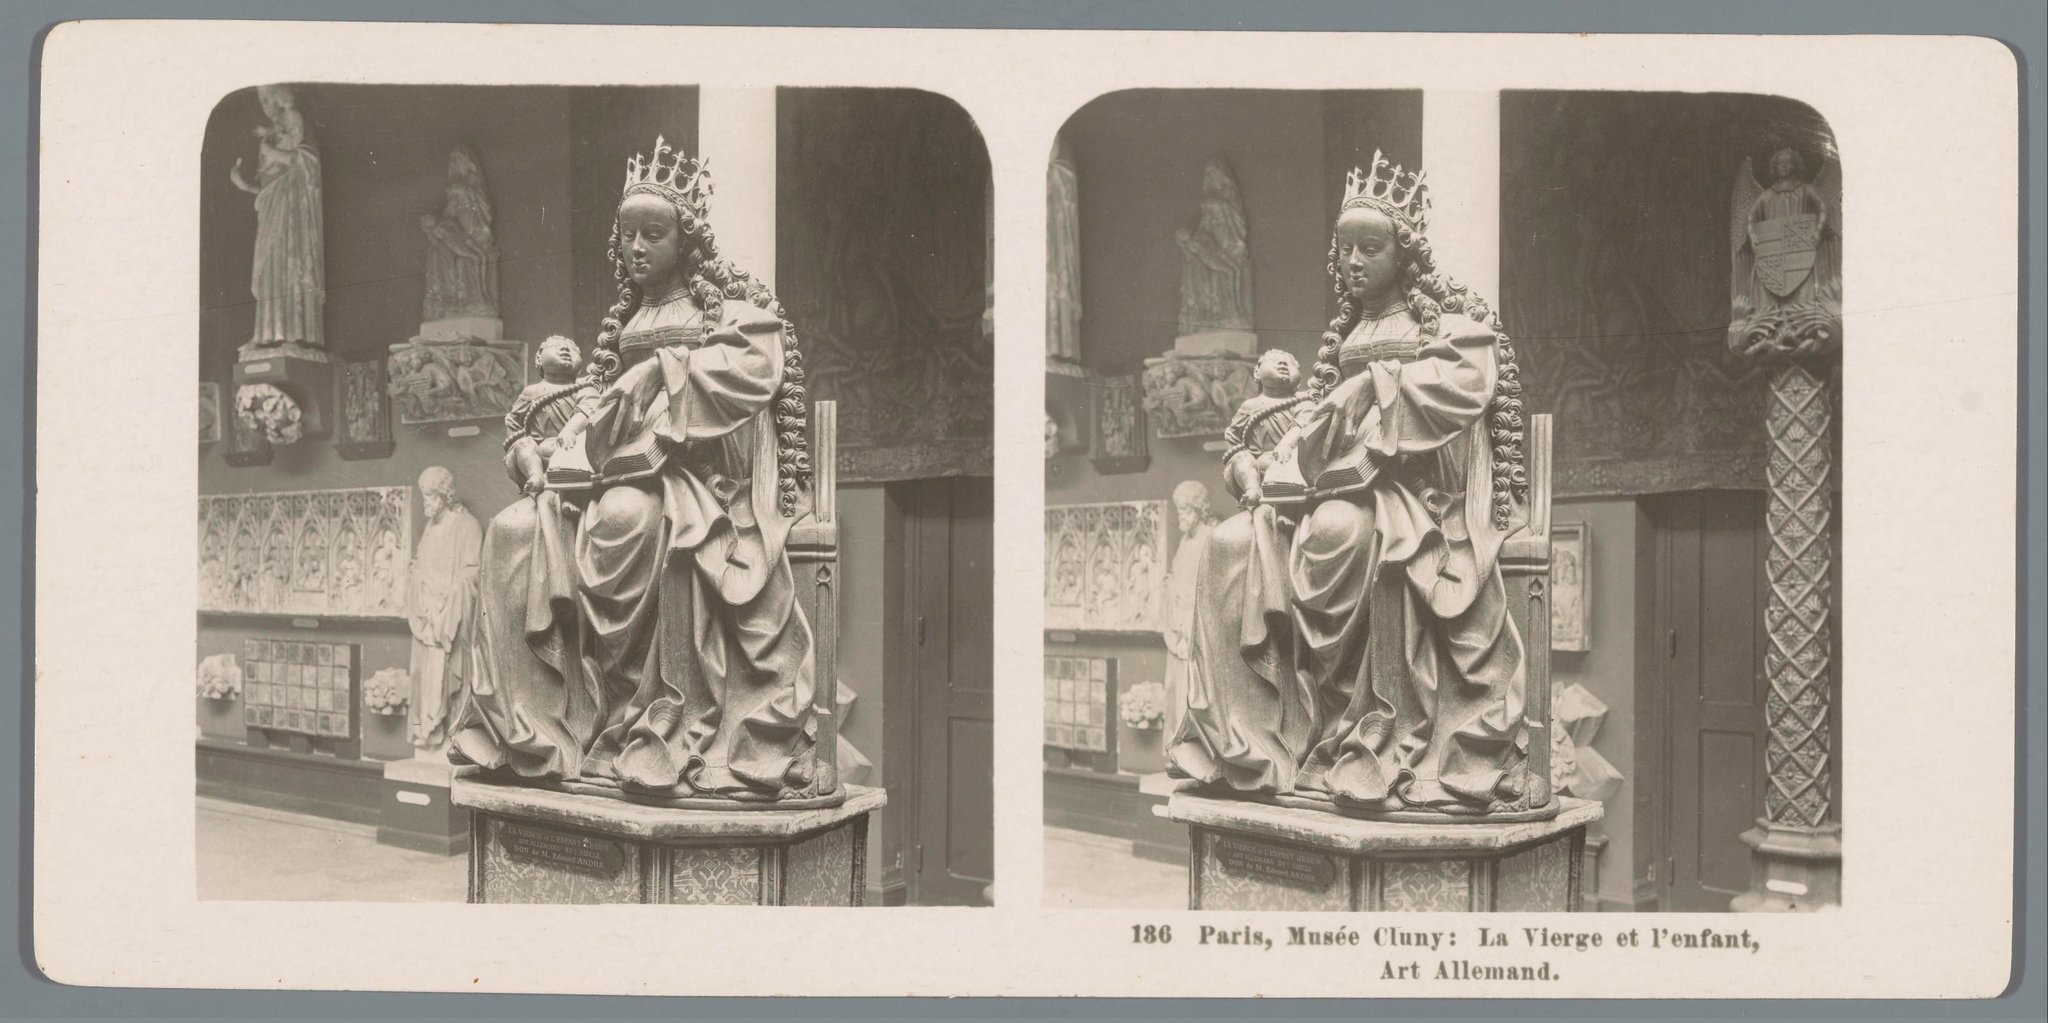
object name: stereograph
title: Sculptuur van in het Musée de Cluny te Parijs, voorstellende Maria met Kind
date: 1903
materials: cardboard, photographic support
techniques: gelatin silver print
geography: musée de cluny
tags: madonna: i.e. mary with the christ-child, permanent exhibition, museum, sculpture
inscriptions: inscription: ‘Neue Photographische Gesellschaft A.-G. Steglitz-Berlin 1903.’, number: ‘136’